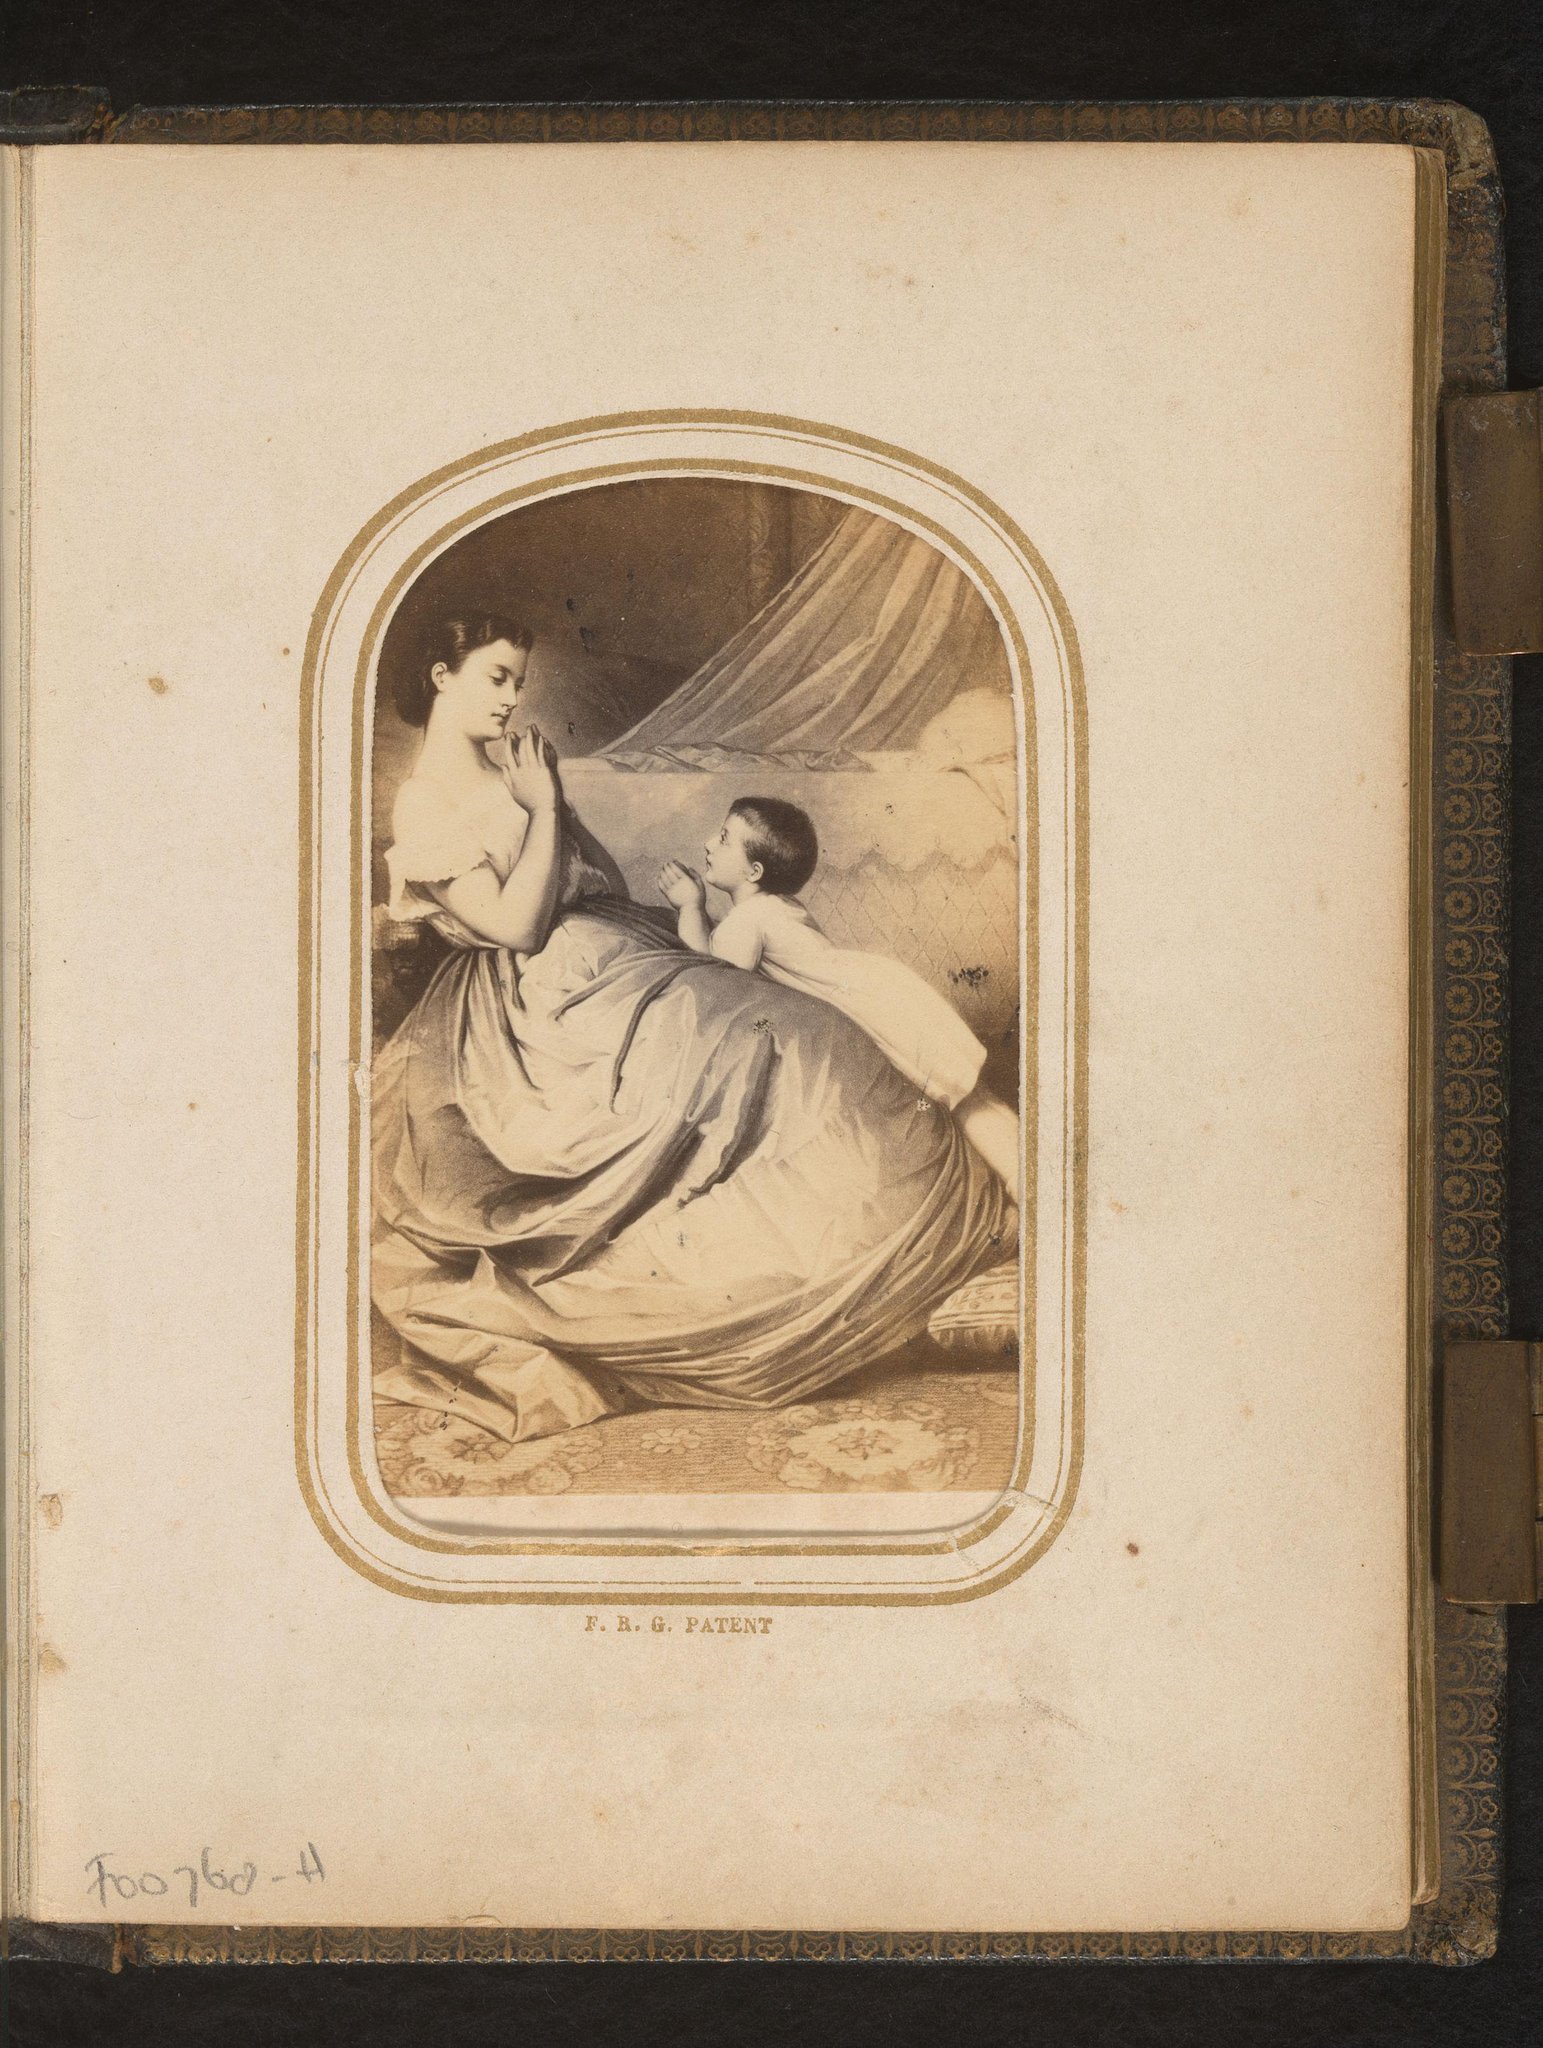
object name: photograph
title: Fotoreproductie van een schilderij van een biddende moeder en kind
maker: Anonymous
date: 1865-1890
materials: cardboard, photographic support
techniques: albumen print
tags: prayer at going to bed, or at getting up, mother and baby or young child, painting, drawing and the graphic arts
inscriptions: number: ‘3573’